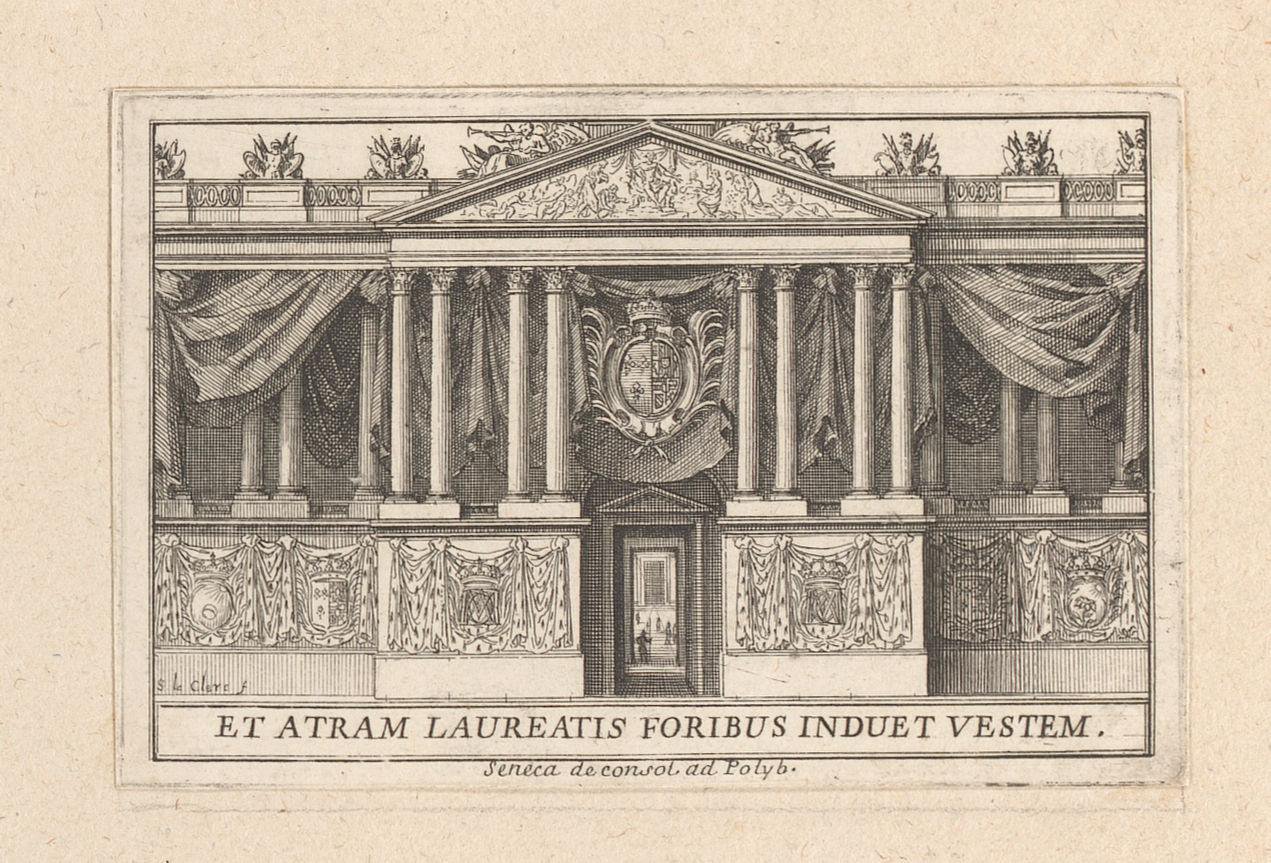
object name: book illustration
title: Vignet met de façade van het Louvre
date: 1684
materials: paper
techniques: etching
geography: paris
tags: vignette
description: Prent uit: Cureau de La Chambre, Abbé Pierre. Oraison funebre de Marie Terese d'Austriche (...). Parijs: Gabriel Martin, 1684.